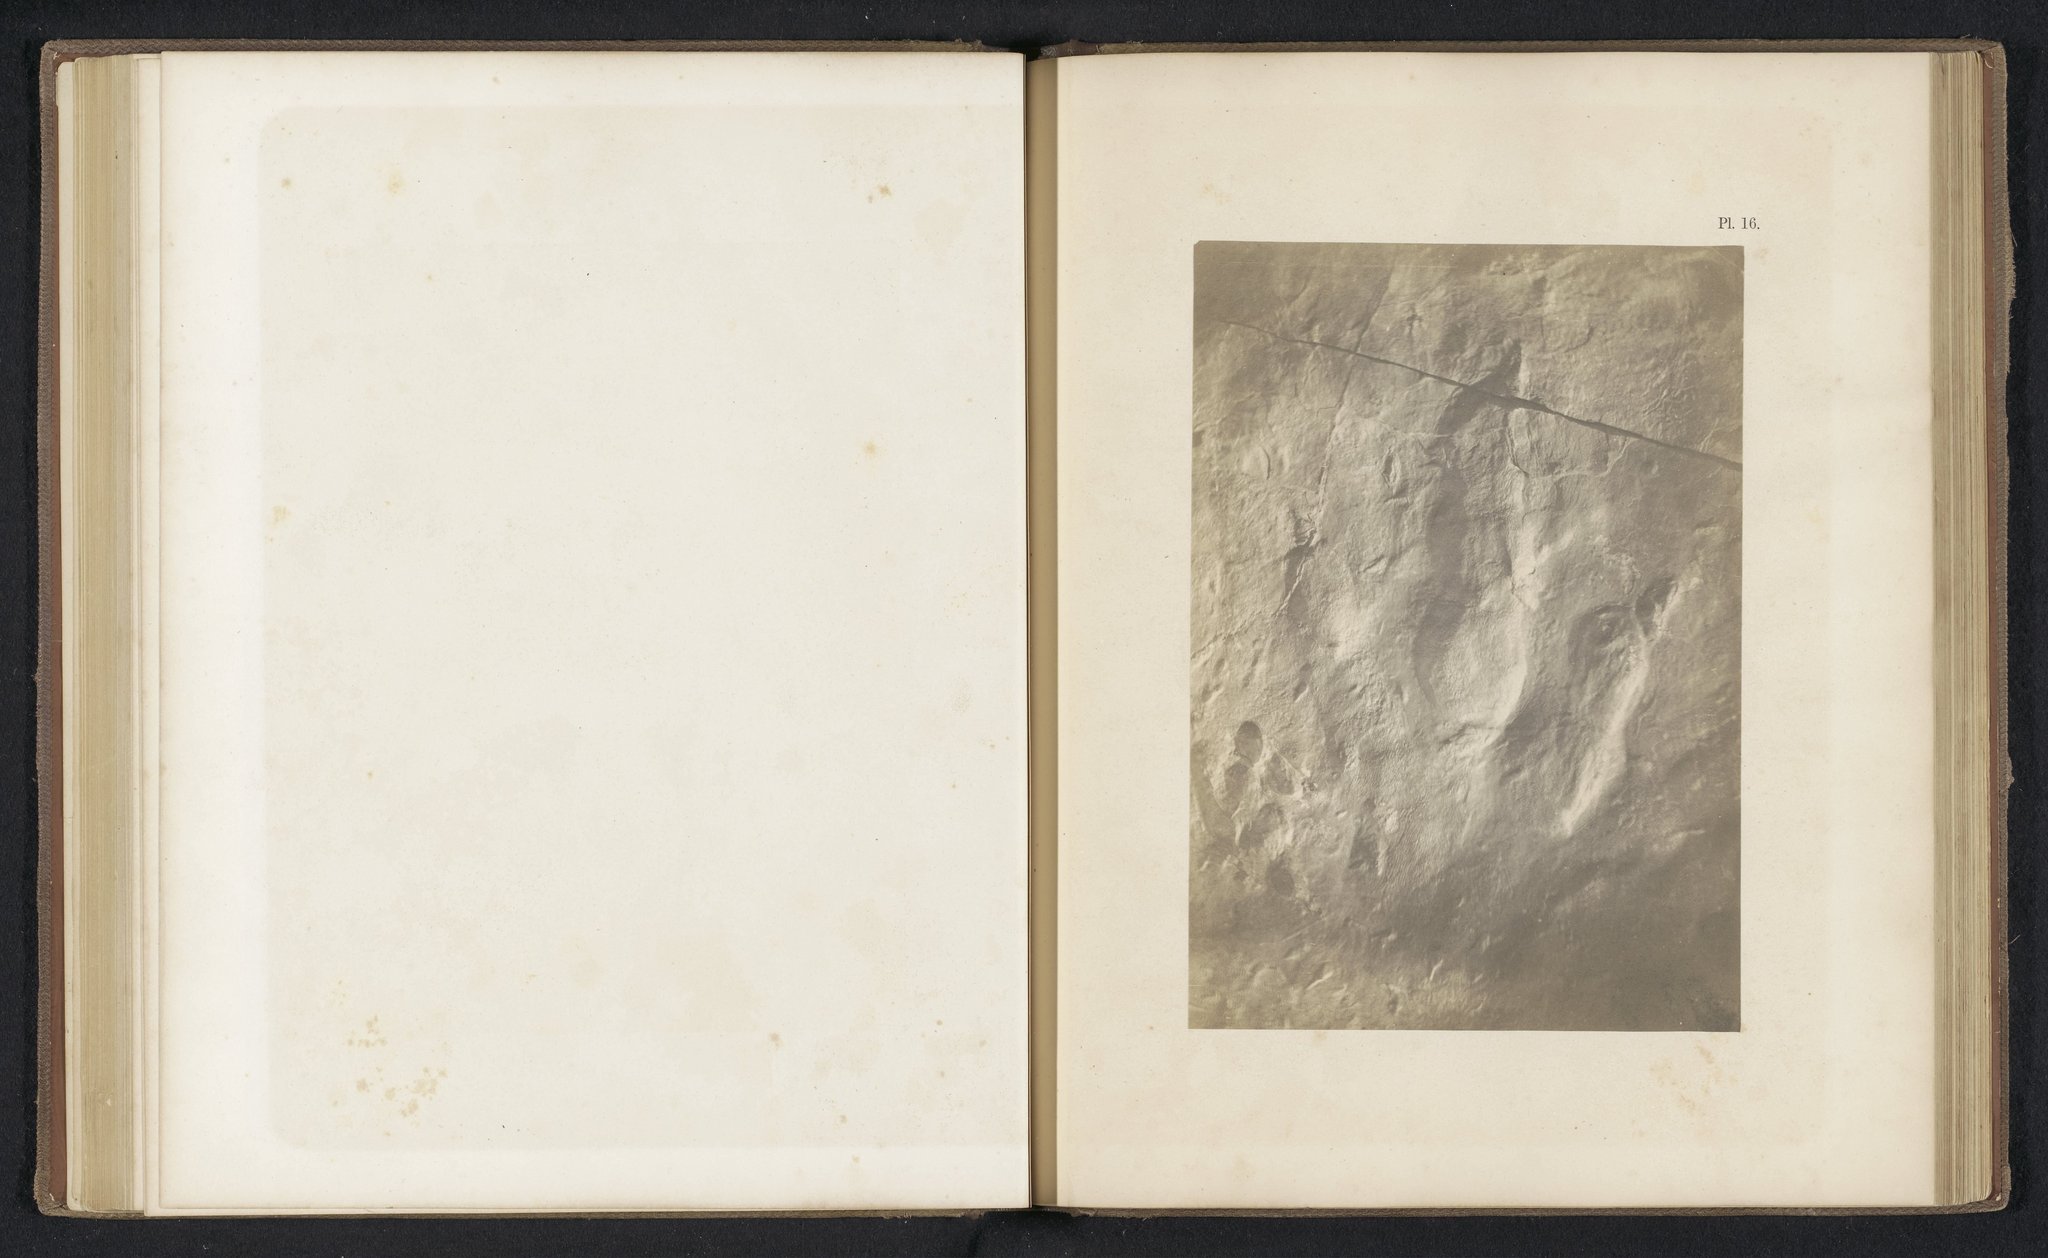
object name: photograph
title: Voetsporen van een Brontozoum minisculum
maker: Anonymous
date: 1850-1861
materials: photographic support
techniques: salted paper print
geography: united states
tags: foot-print, track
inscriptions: number: ‘Pl. 16.’